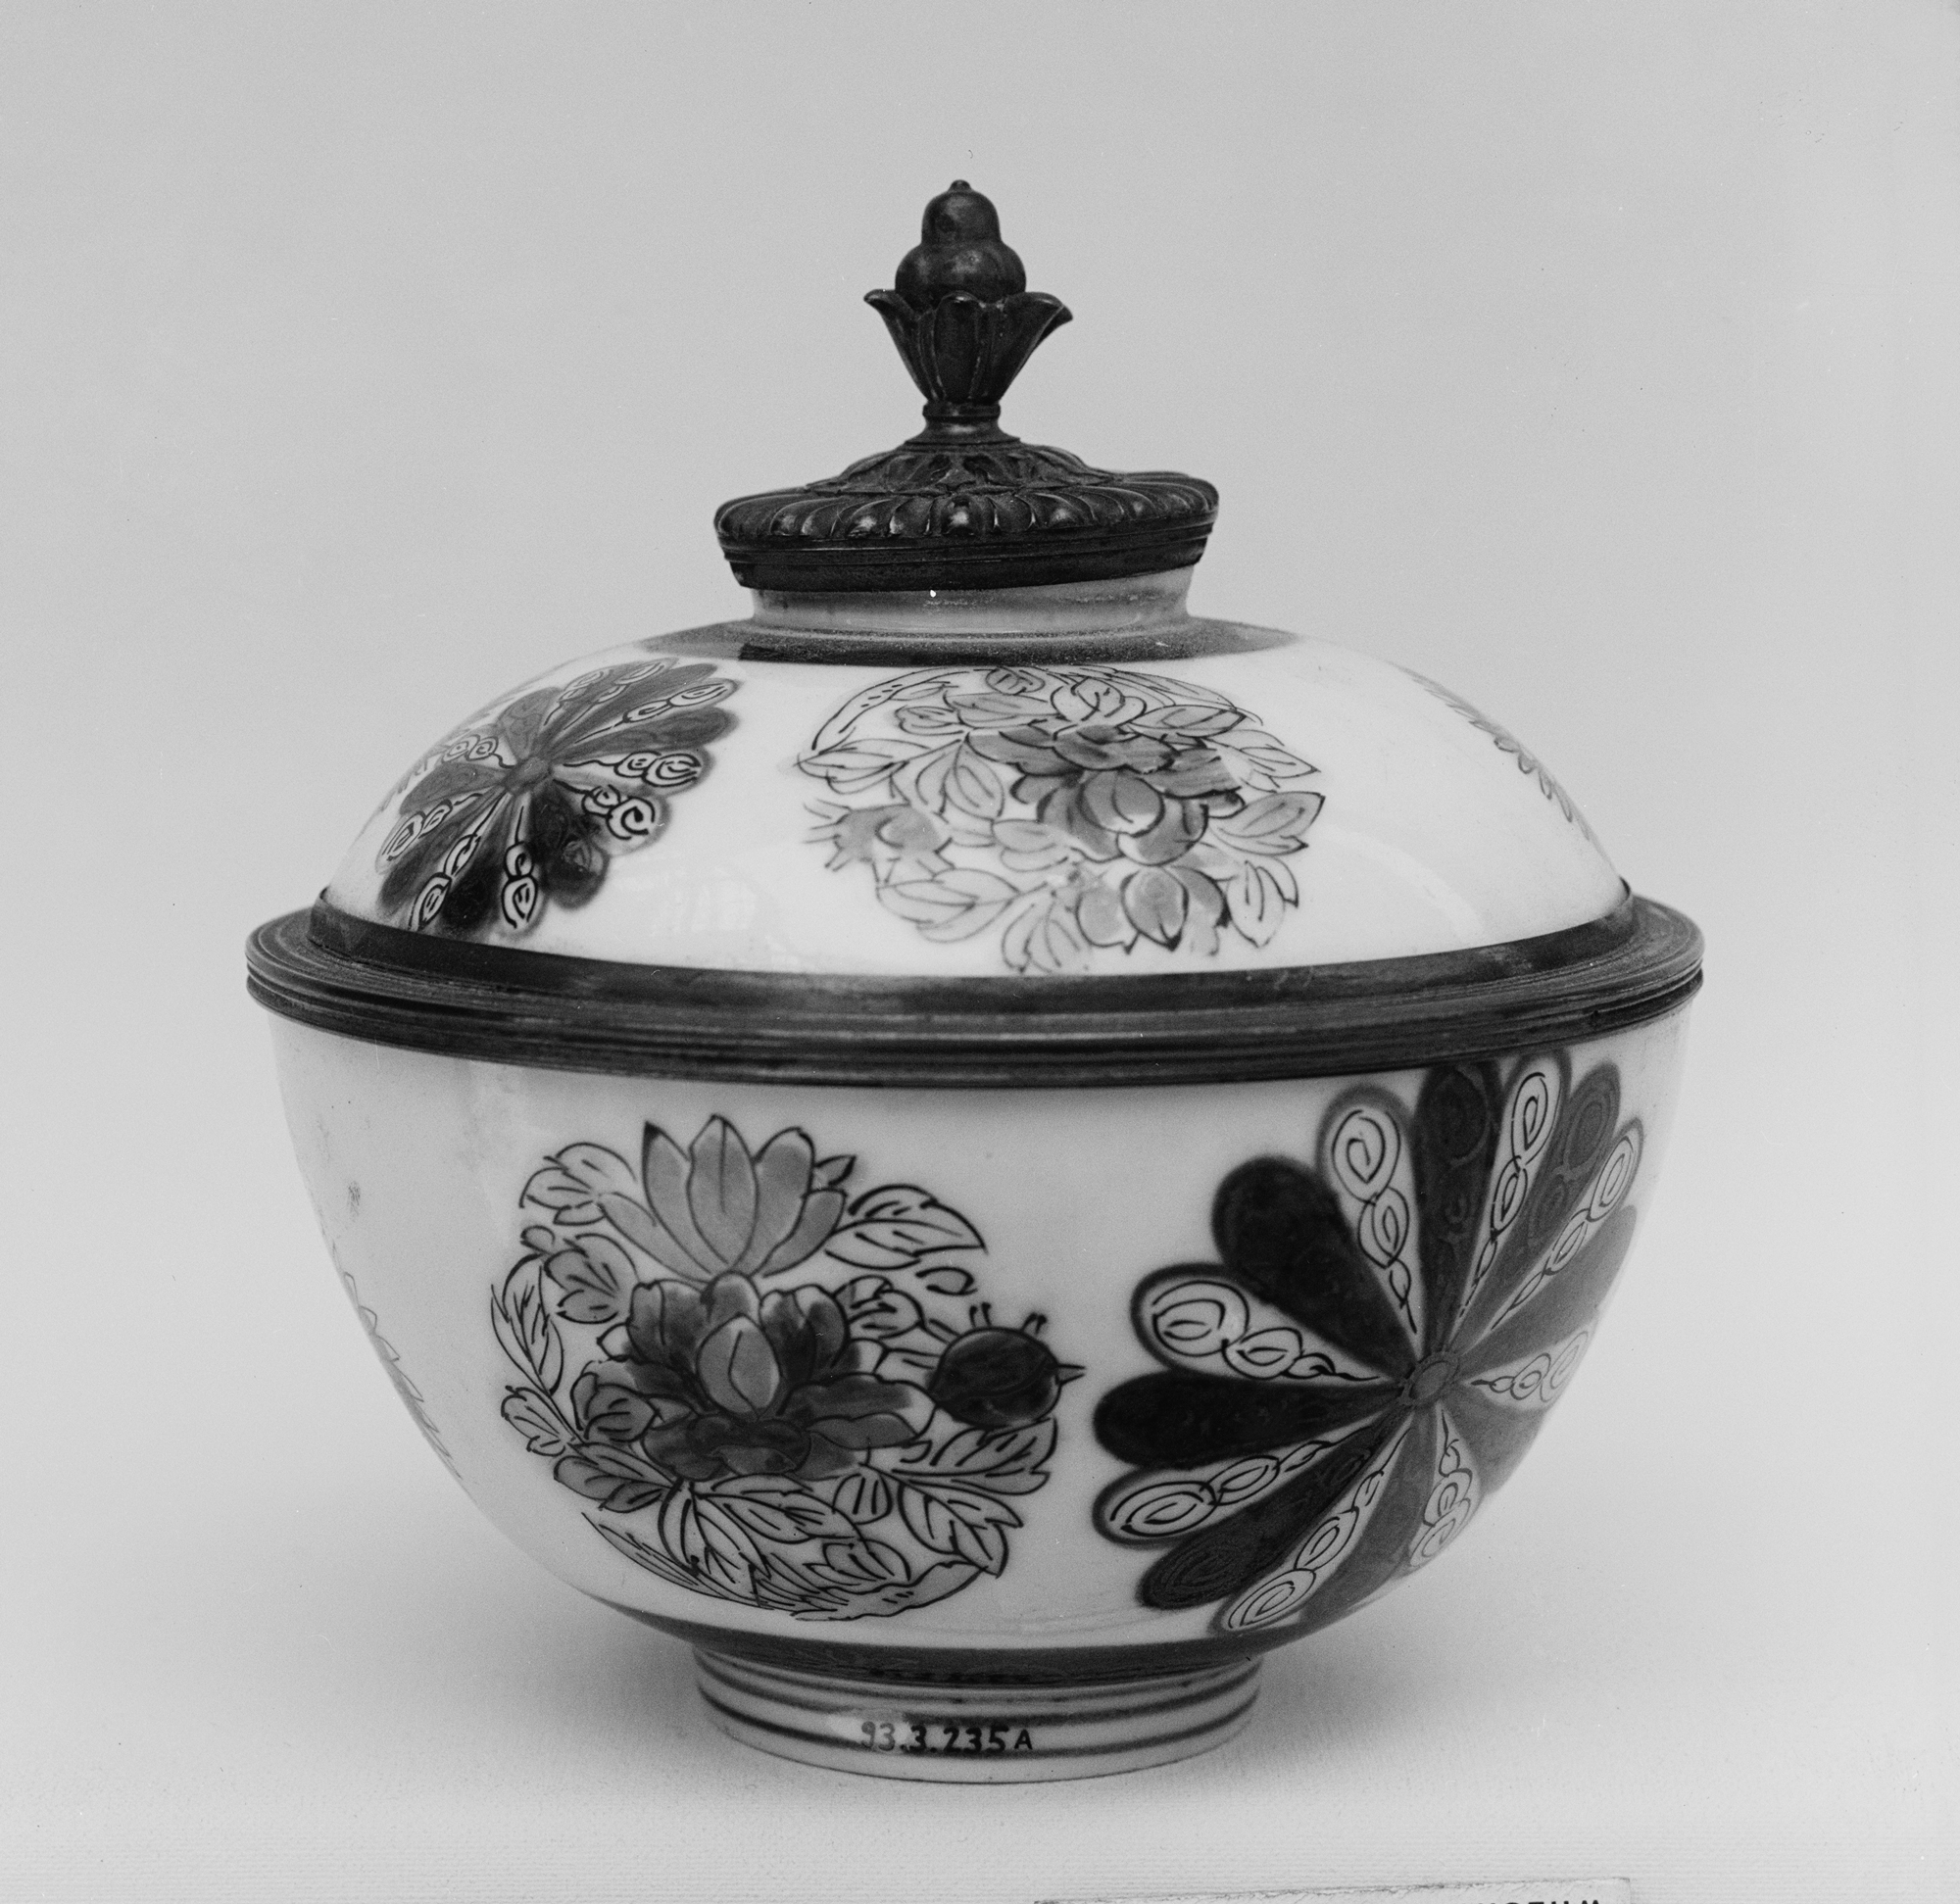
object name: bowl with cover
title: Bowl and Cover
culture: japanese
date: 1701-1800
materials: enamel, glaze, gold, porcelain, silver